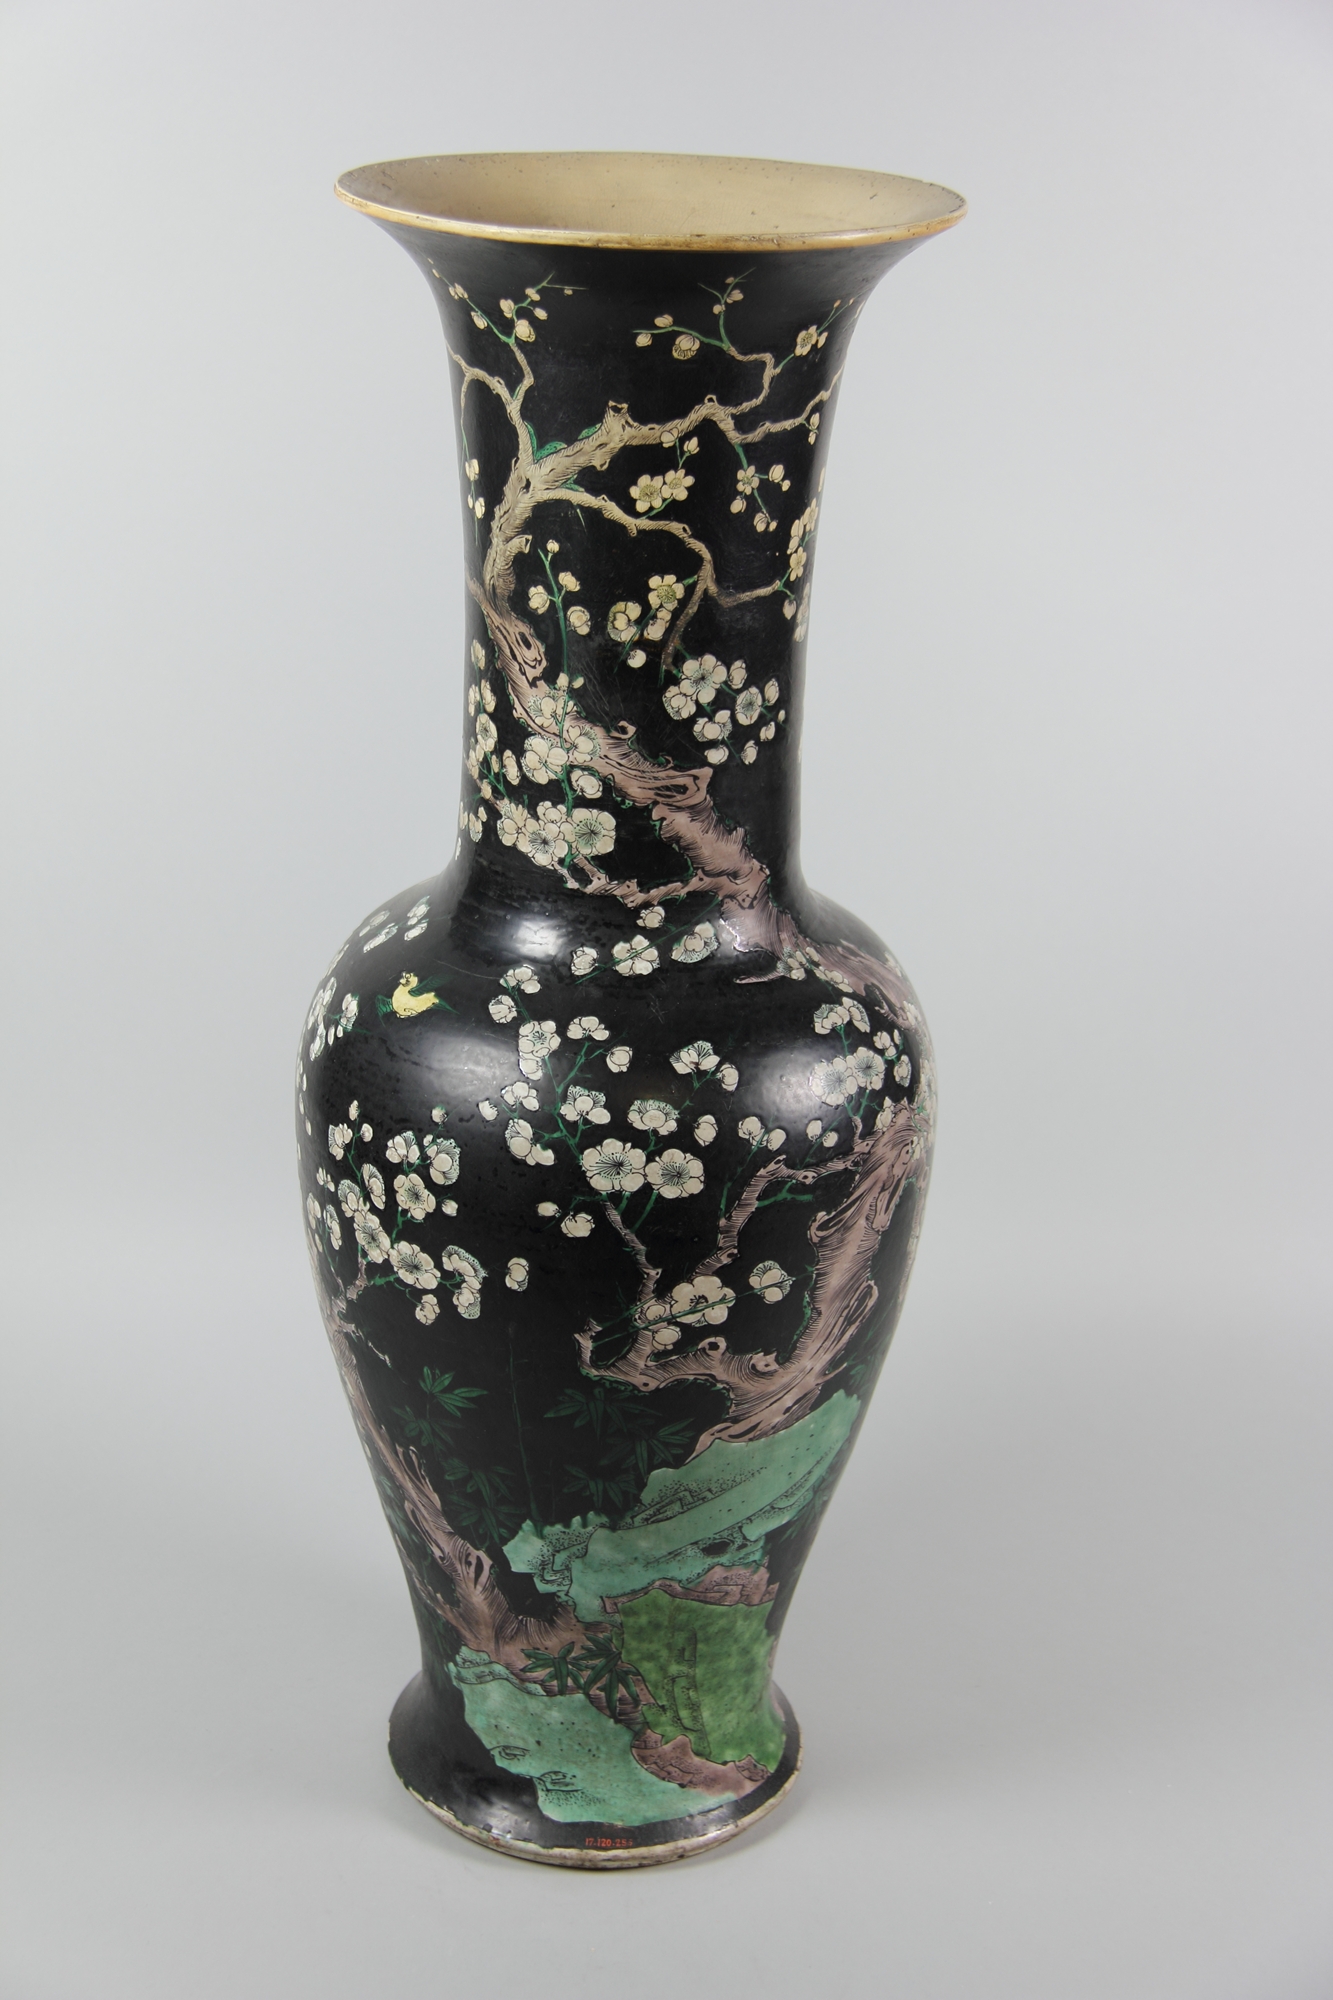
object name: vase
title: Vase with birds and flowers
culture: chinese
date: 1801-1900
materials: enamel, porcelain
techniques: painting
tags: flowers,trees